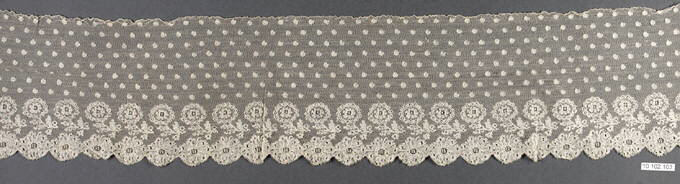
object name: piece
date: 1767-1800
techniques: lace